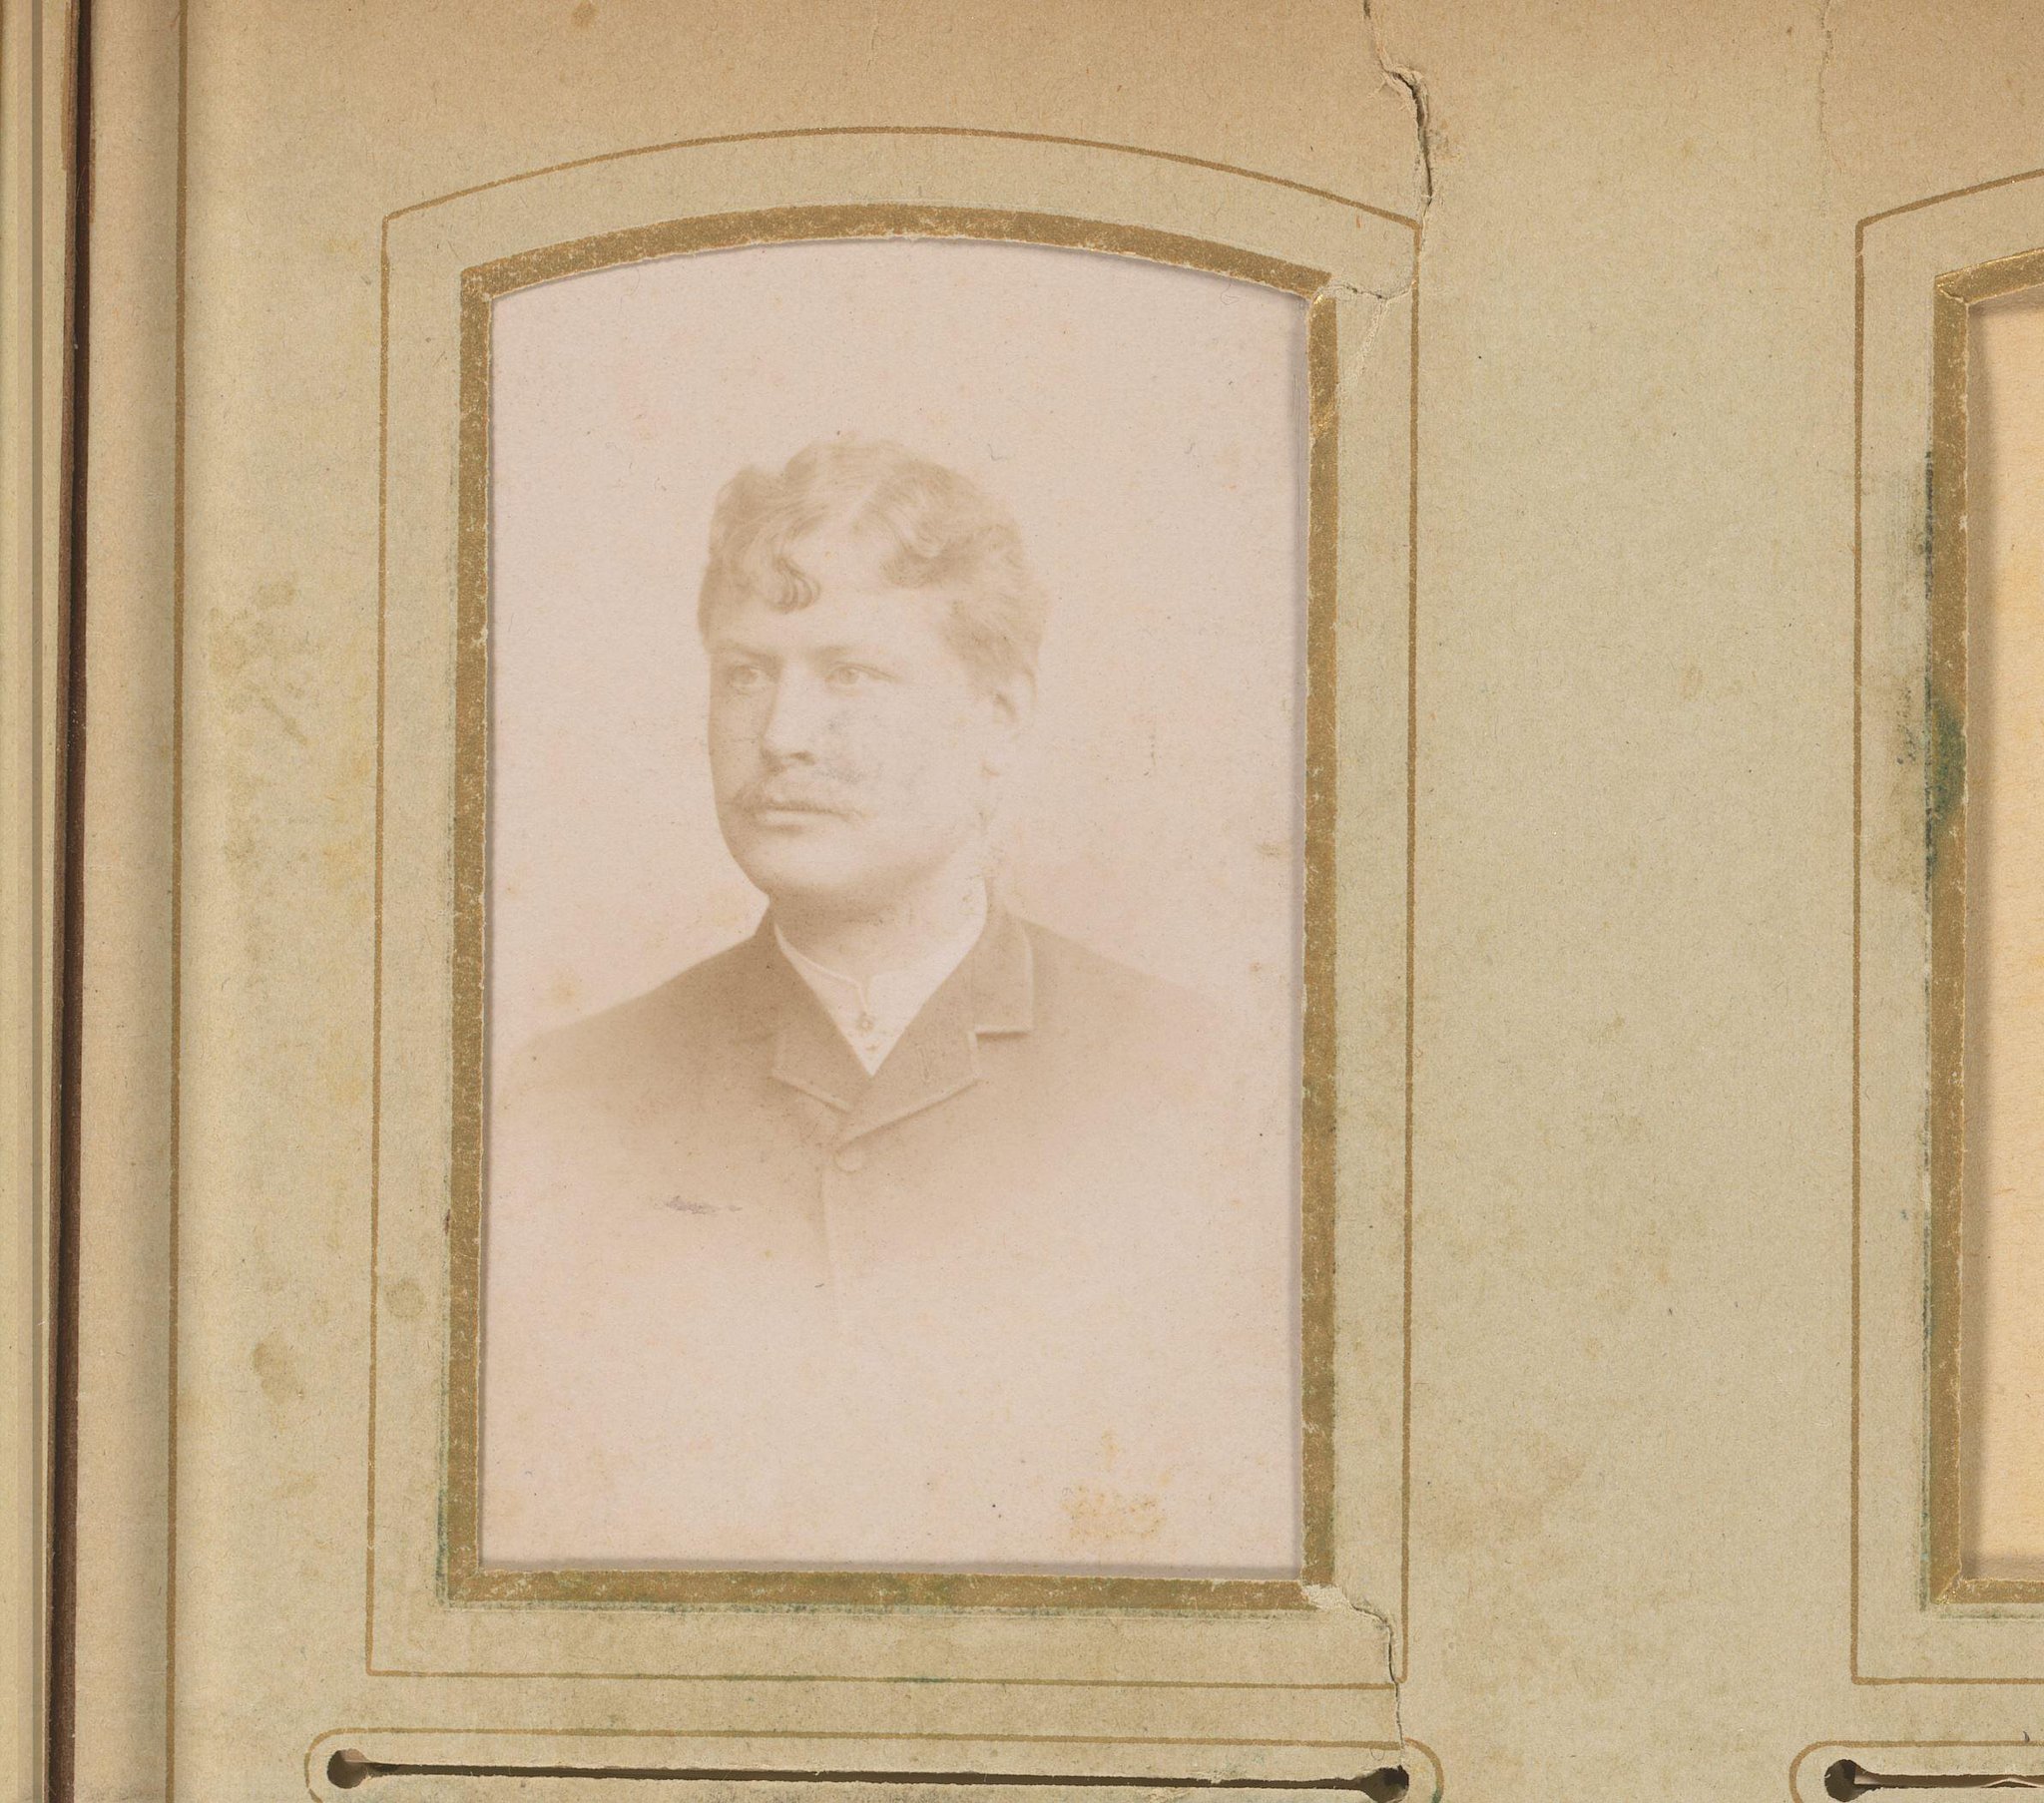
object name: photograph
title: Portret van een man met snor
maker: j. van crewel jeune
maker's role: fotograaf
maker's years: 1852-1930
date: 1883-1905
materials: cardboard, photographic support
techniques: albumen print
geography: antwerp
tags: moustache, historical persons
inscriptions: inscription: ‘Les plus hautes Récompese obtenues à différentes Expositions./ Brevet d'invention. (...)/ J. van Crewel Jeune/ Photographe Breveté/ 48. Rue du Pélican 48,/ en face de la Gare de l'Est./ Anvers./ Galerie de Pose dans le Jardin.’